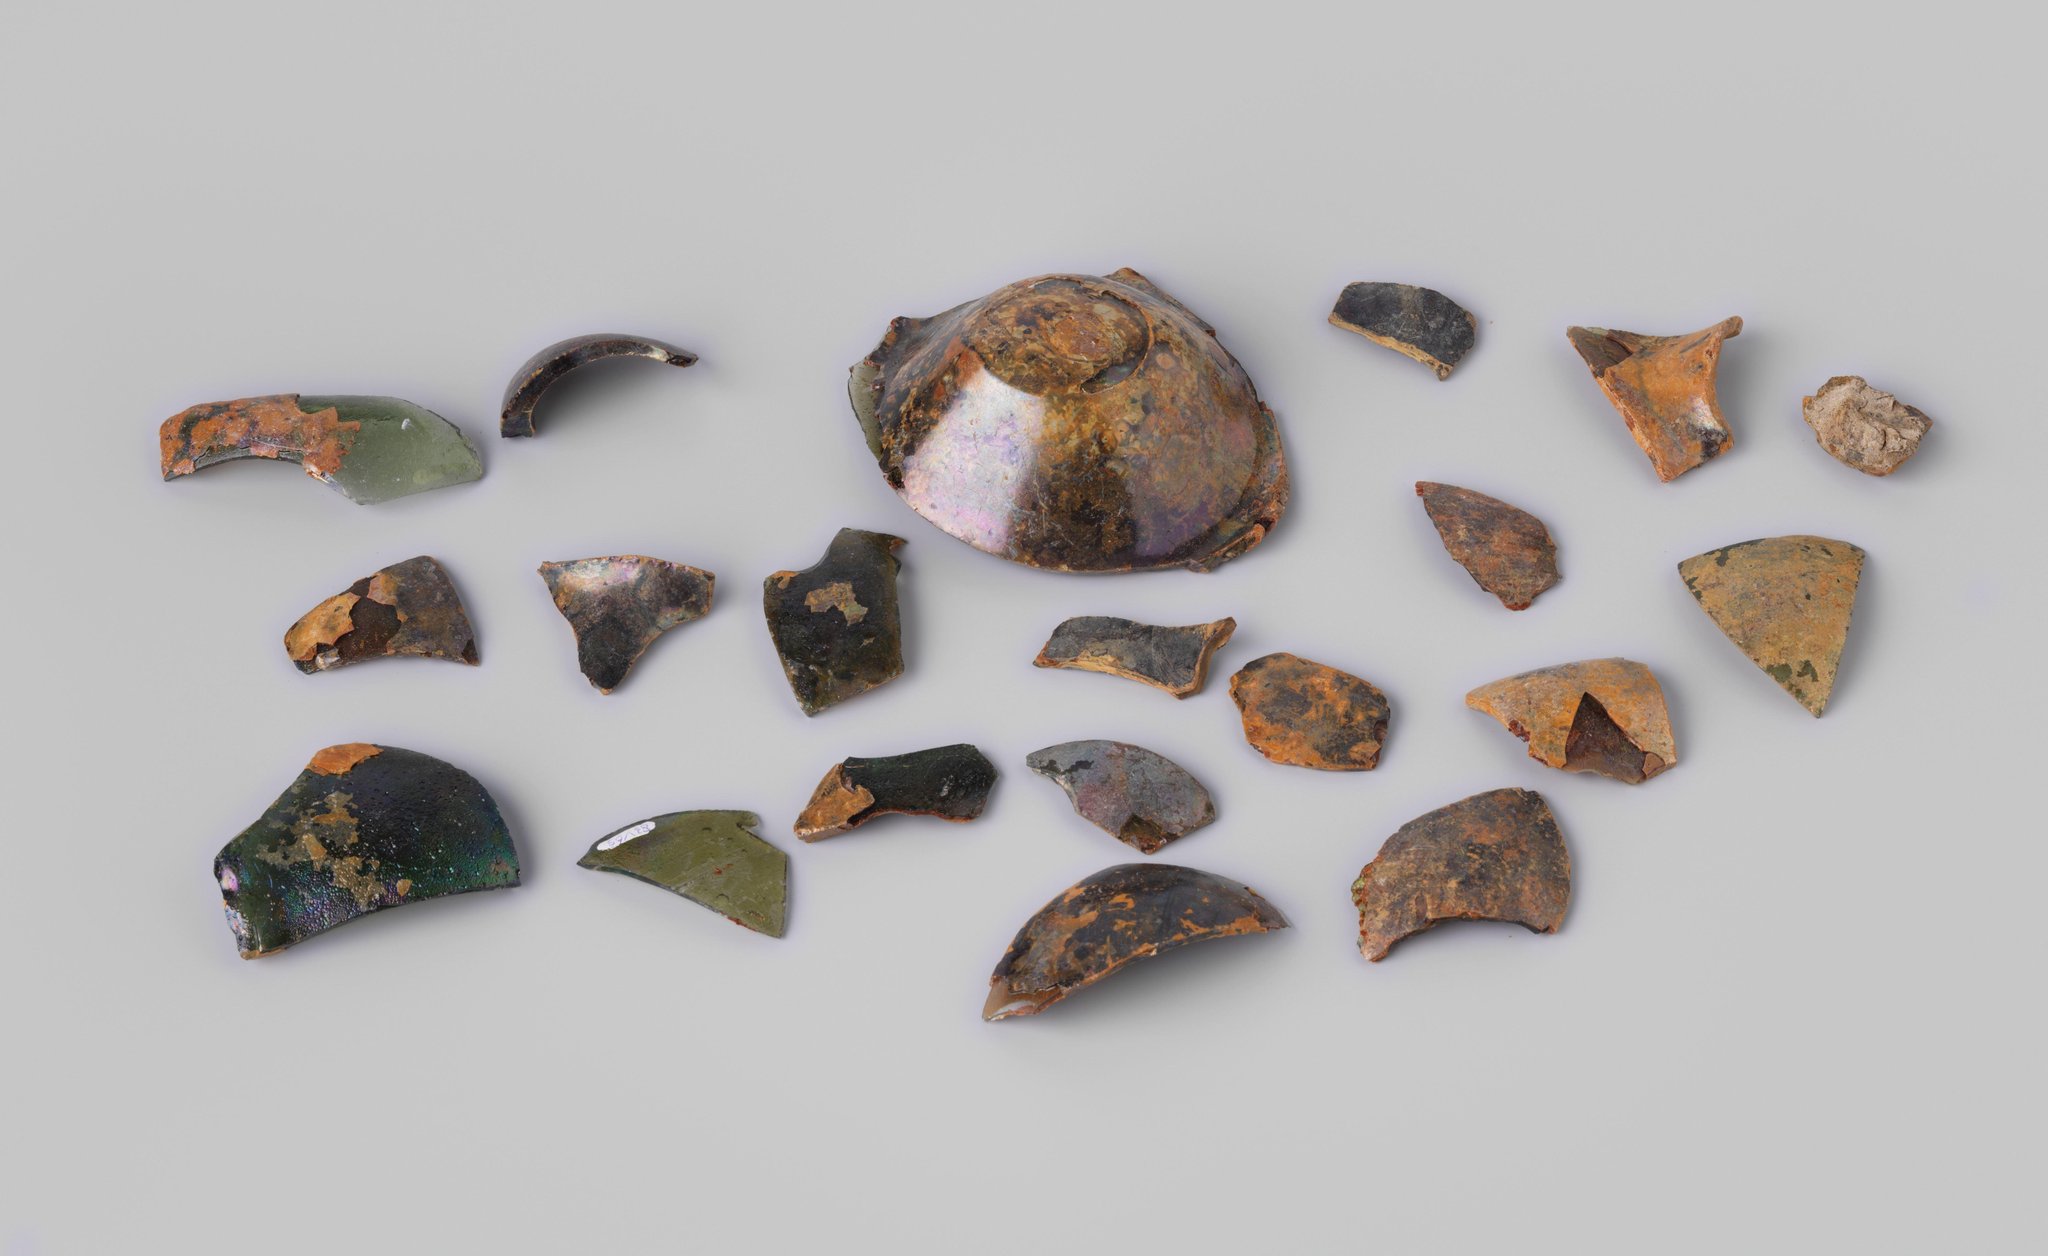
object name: sherd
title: Scherven van wijnflessen uit het wrak van de Oost-Indiëvaarder 't Vliegend Hart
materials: glass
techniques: green glass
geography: netherlands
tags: 't vliegend hart (schip), verenigde oostindische compagnie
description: Scherven van uivormige wijnflessen van groen glas waar rode (port)wijn in heeft gezeten.